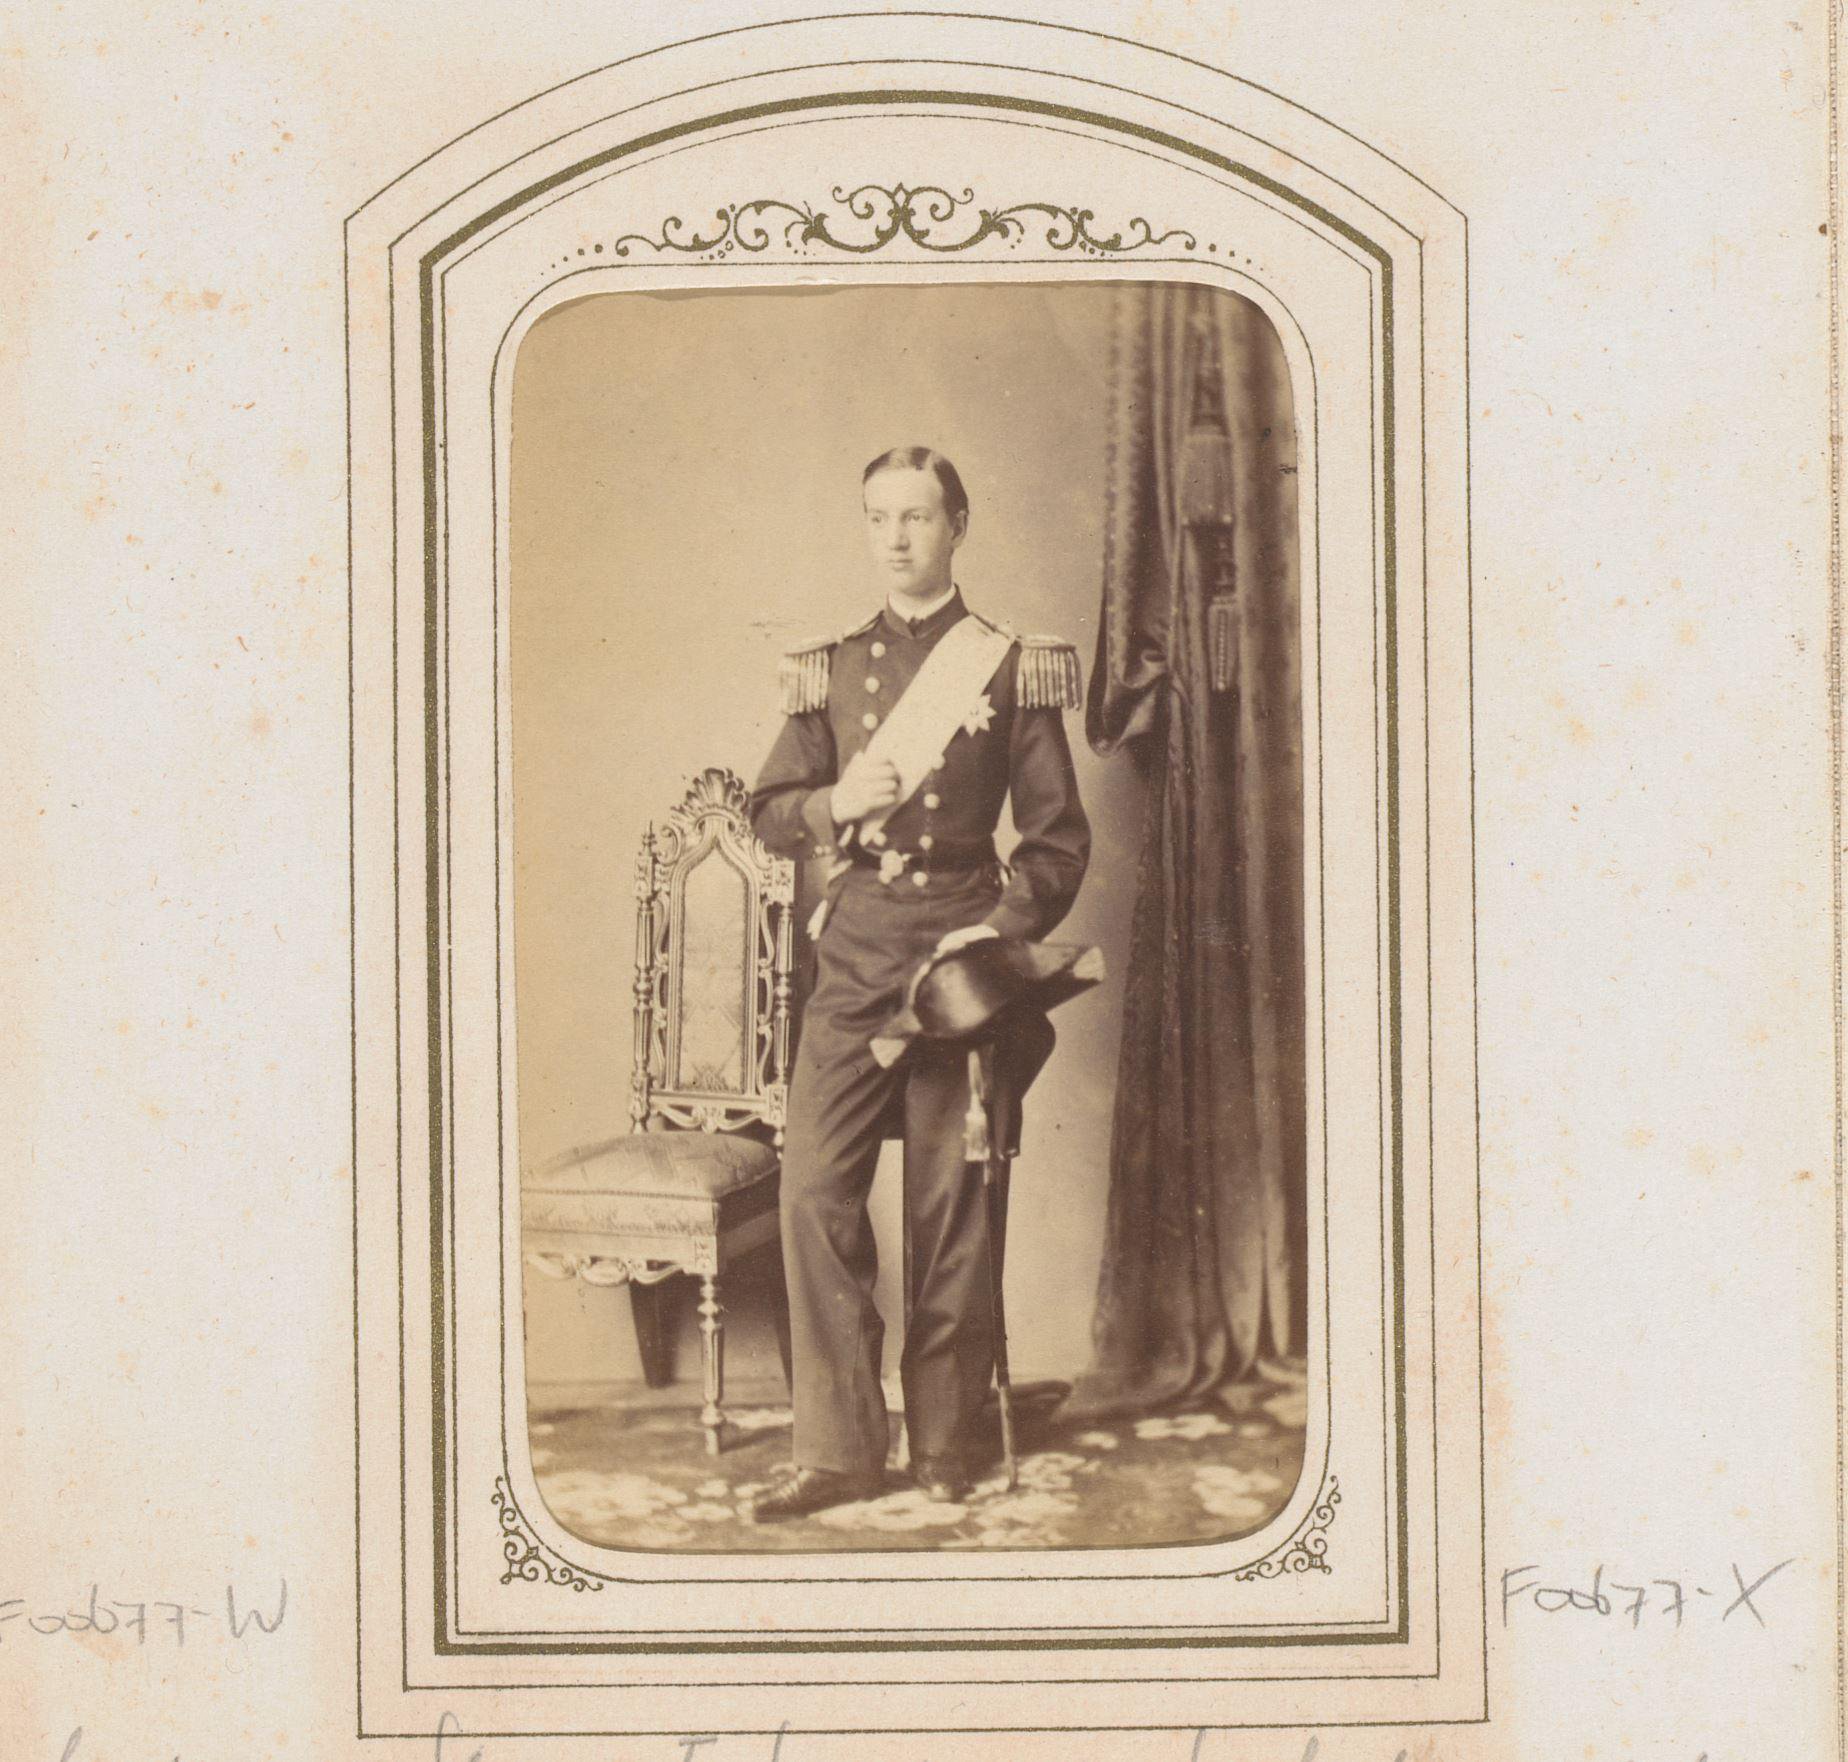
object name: photograph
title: Portret van George I, koning van Griekenland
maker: georg emil hansen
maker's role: fotograaf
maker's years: 1833-1891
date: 1863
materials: cardboard, photographic support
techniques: albumen print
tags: copenhagen (city), historical persons, king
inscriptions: inscription: ‘GEORG E. HANSEN/ kongl. Hof-/ PHOTOGRAPH/ Norgesgade 61,/ Hjörnet af Toldbodveien/ KIÖBENHAVN.’, number: ‘8’, annotation: ‘George I koning van Griekenland, geb/ prins van Denemarken (845-1913/ koning vanaf 31-10-1863’